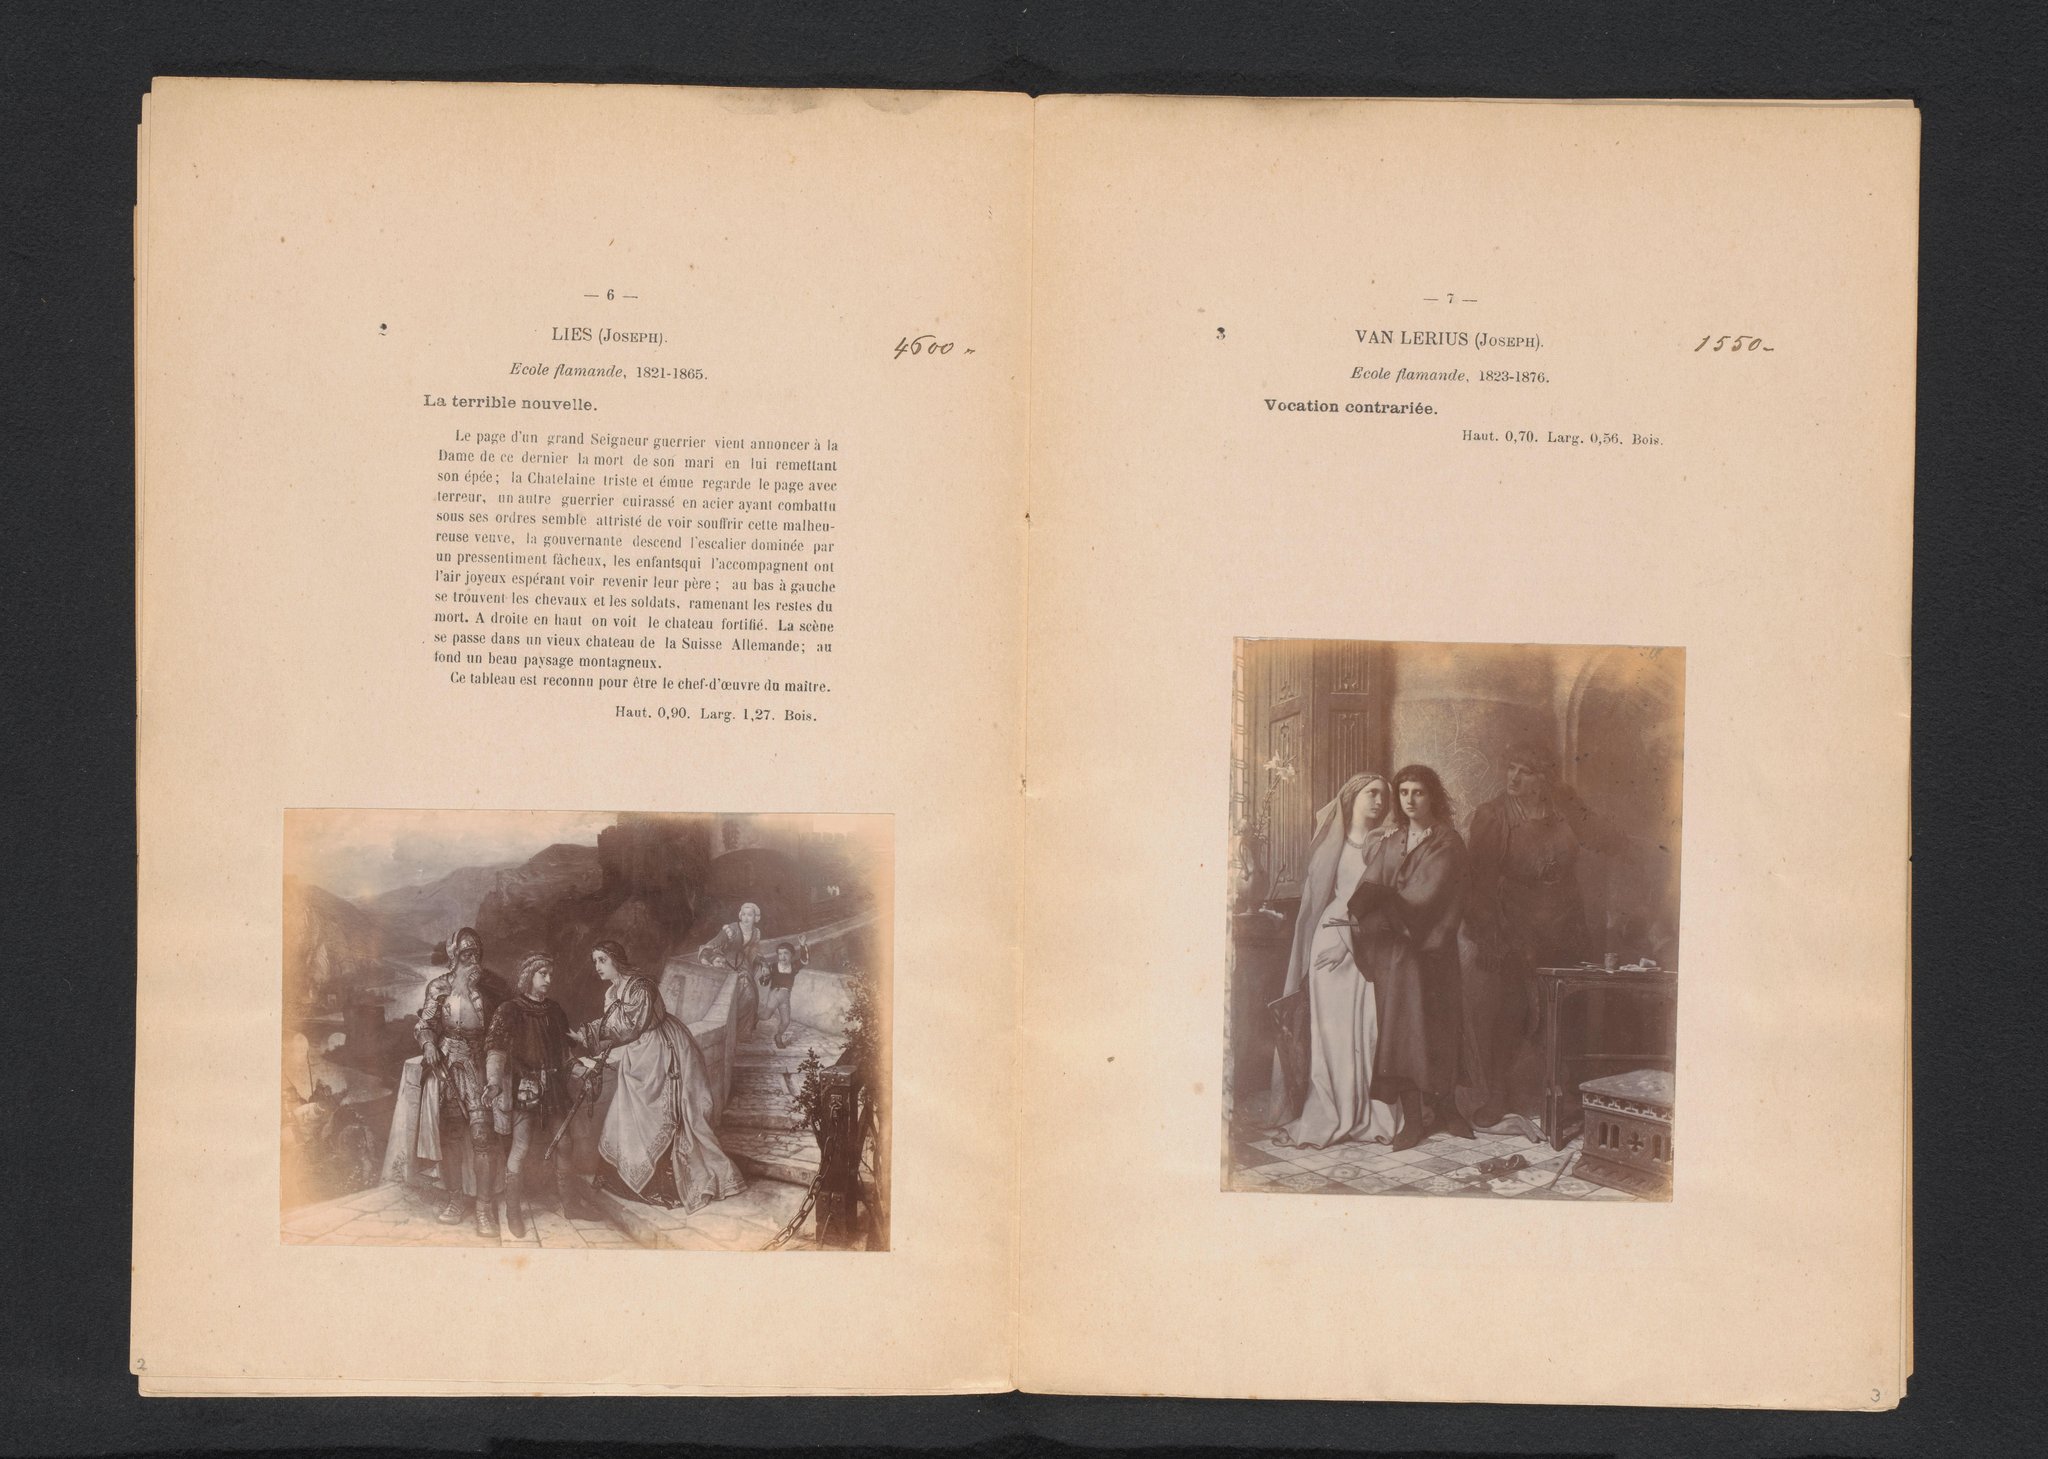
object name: photograph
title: Fotoreproductie van een schilderij van twee soldaten en een vrouw op een trap voor een kasteel door Joseph Lies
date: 1886-1891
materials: photographic support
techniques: gelatin silver print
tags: fortress, the soldier; the soldier's life